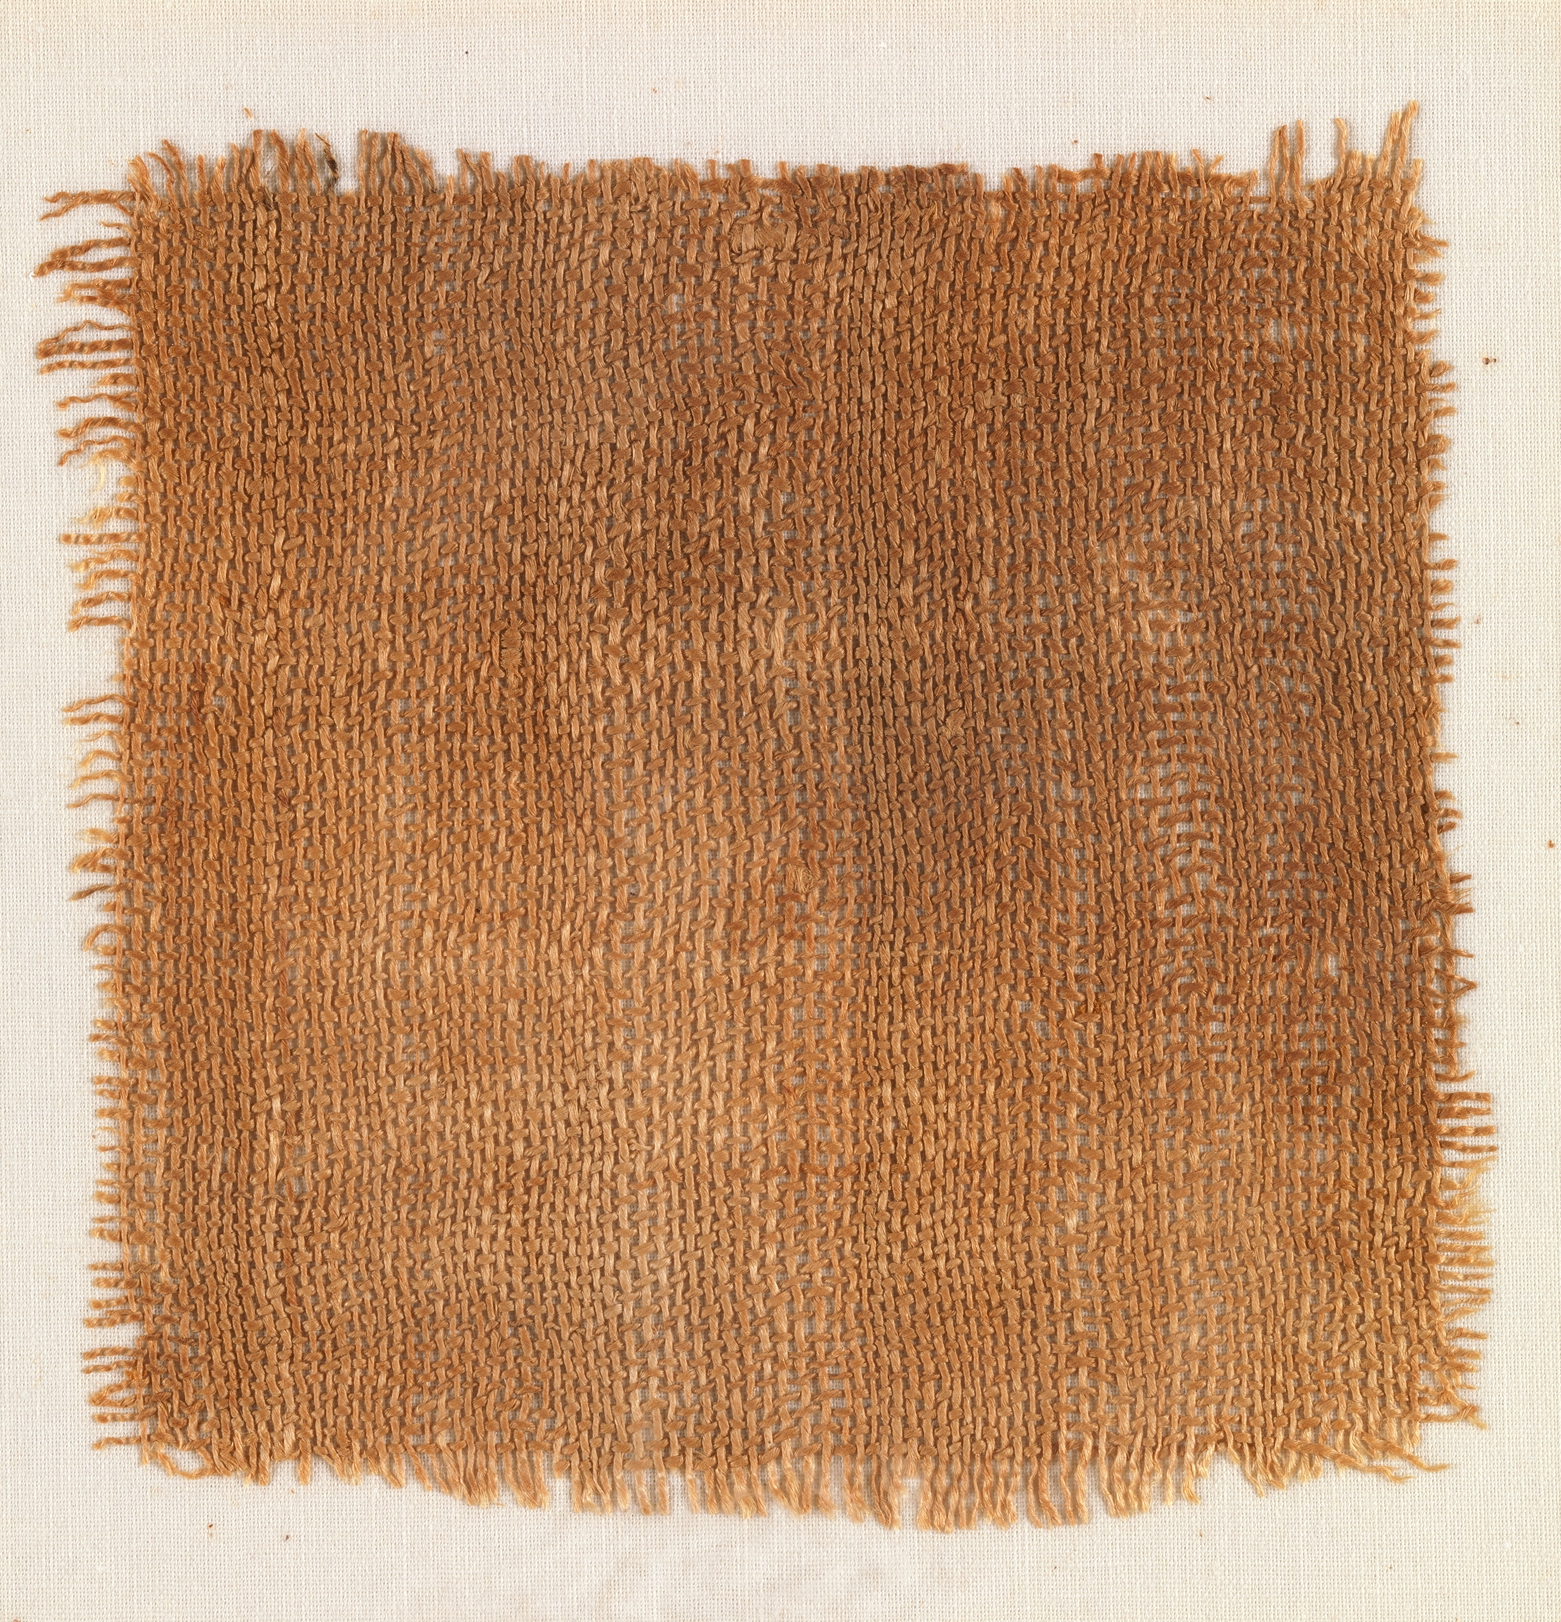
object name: linen sample, unis, mummy cloth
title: Sample of Cloth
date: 2353-2323 BCE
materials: linen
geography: egypt